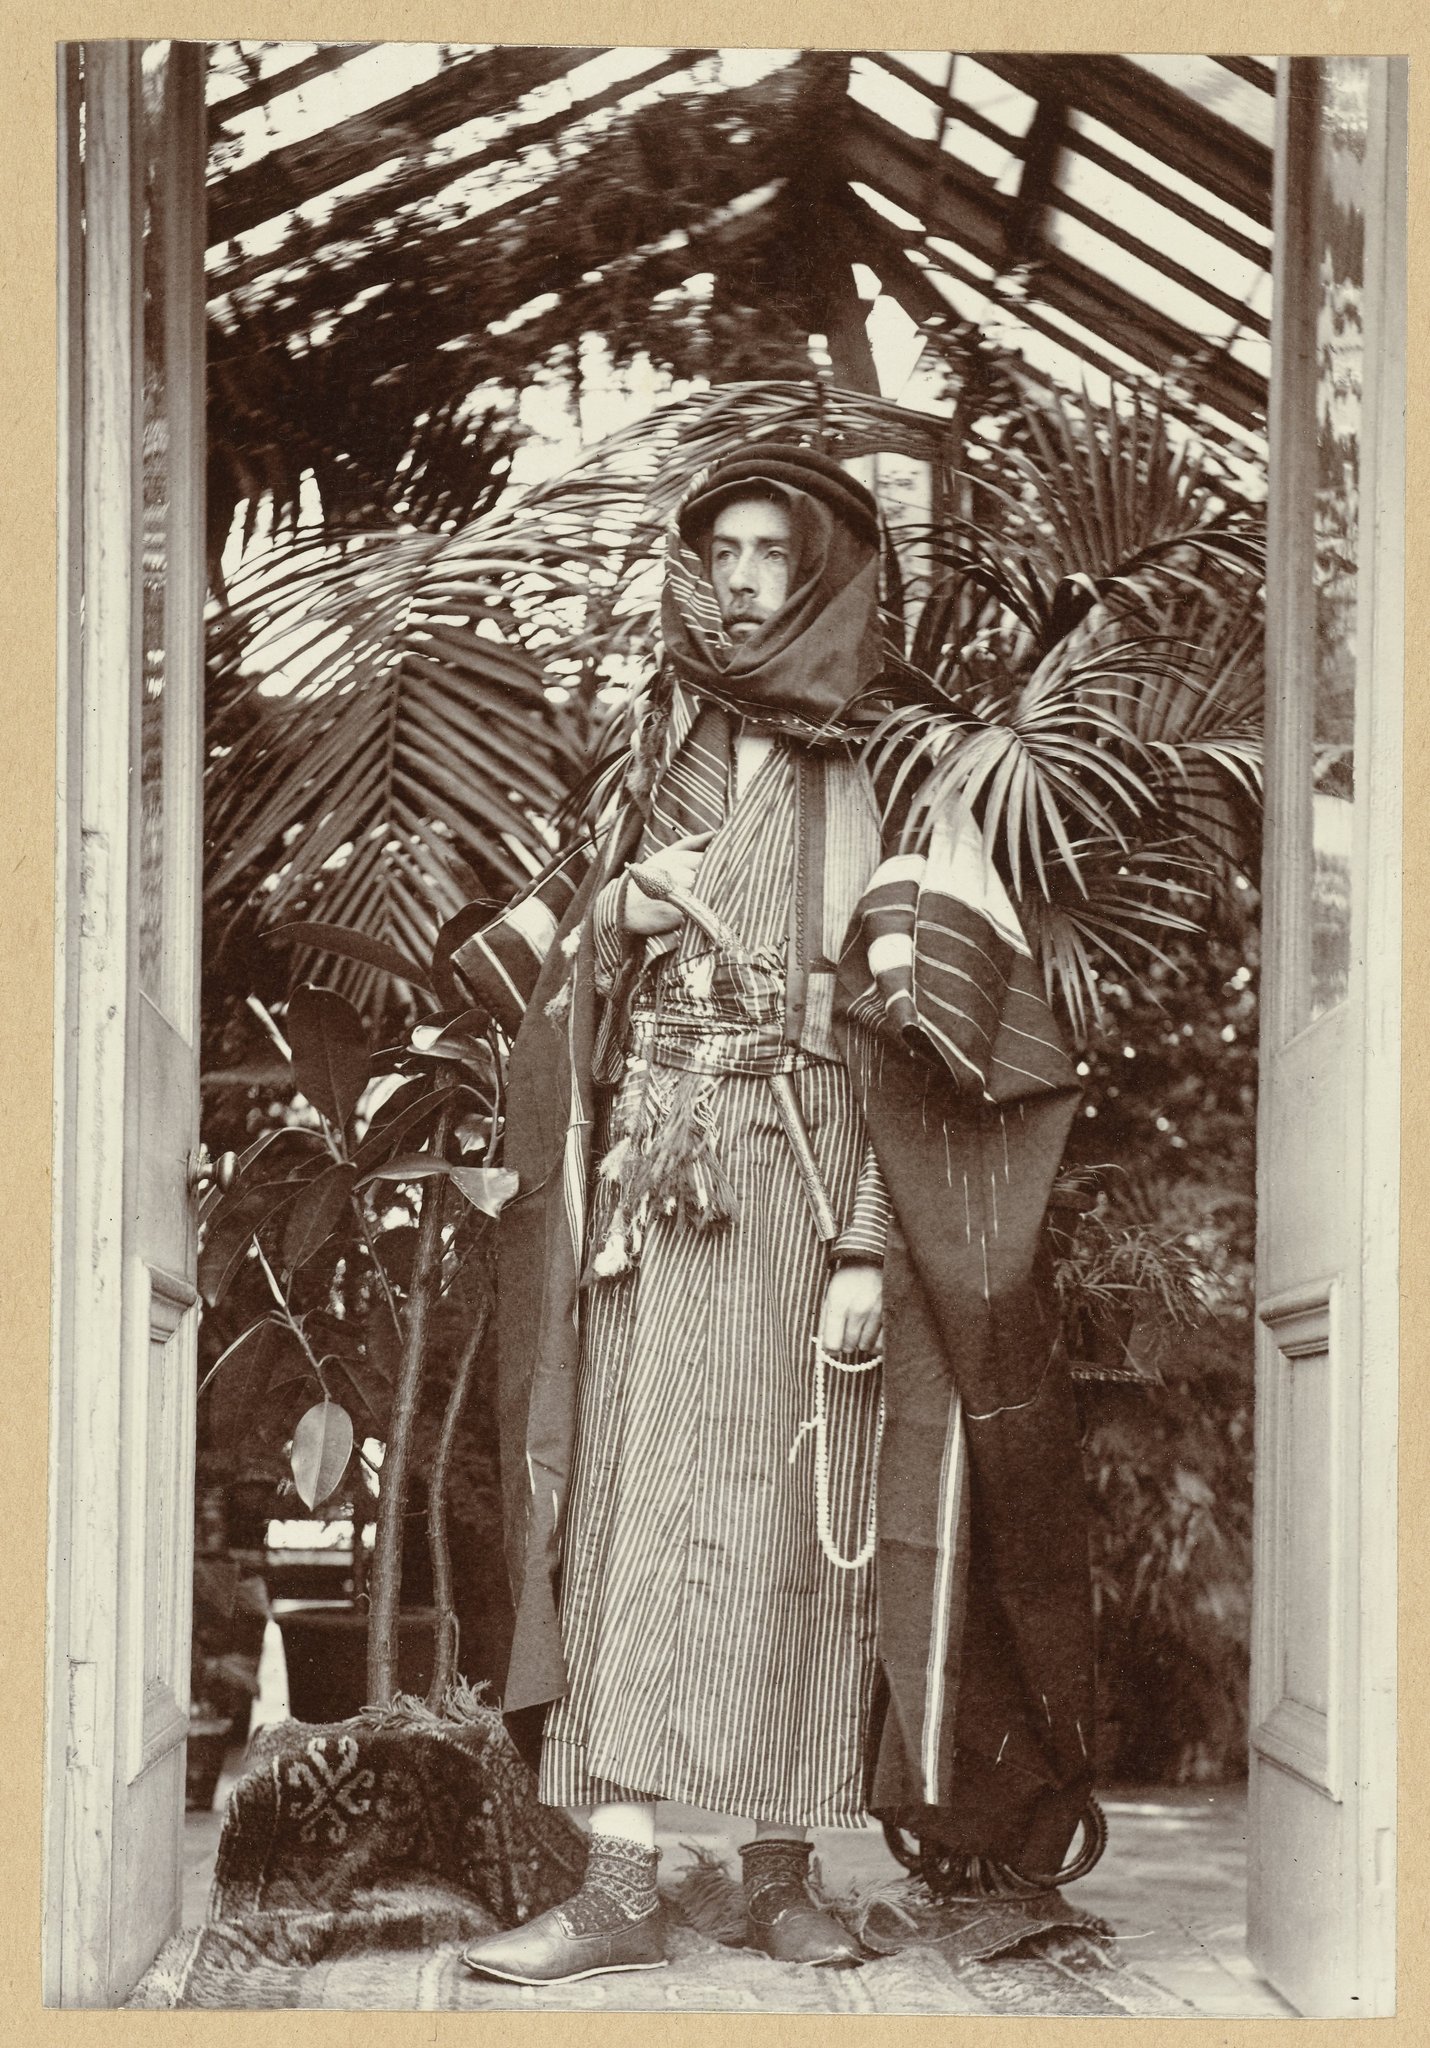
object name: photograph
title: Zelfportret in "oriëntaals" kostuum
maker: mr. l. de bruyn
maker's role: fotograaf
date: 1900-1910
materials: paper, cardboard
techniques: collodion silver print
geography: egypt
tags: mr. l. de bruyn, historical persons, folk costume, regional costume, portrait, self-portrait of photographer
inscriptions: check stamp: ‘Bristol/ L.M.’, stamp: ‘Gemeentelijke bibliotheek/ Rotterdam’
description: De kleding van de geportretteerde past in het beeld dat in de "Westerse" verbeelding bestond (en bestaat) van de "Oriënt". Onderdeel van een groep door fotograaf Richard Polak op reis verzamelde foto’s. Deze foto is rond 1910 gemaakt door zijn reisgenoot mr. L. de Bruyn. Foto’s die hij op eerdere reizen verzamelde zijn tentoongesteld bij de Rotterdamsche Kunstkring (1895), Arti en Amicitiae te Amsterdam (1897-1898?) en Societeit 't Collegie te Kampen (datum vooralsnog onbekend).